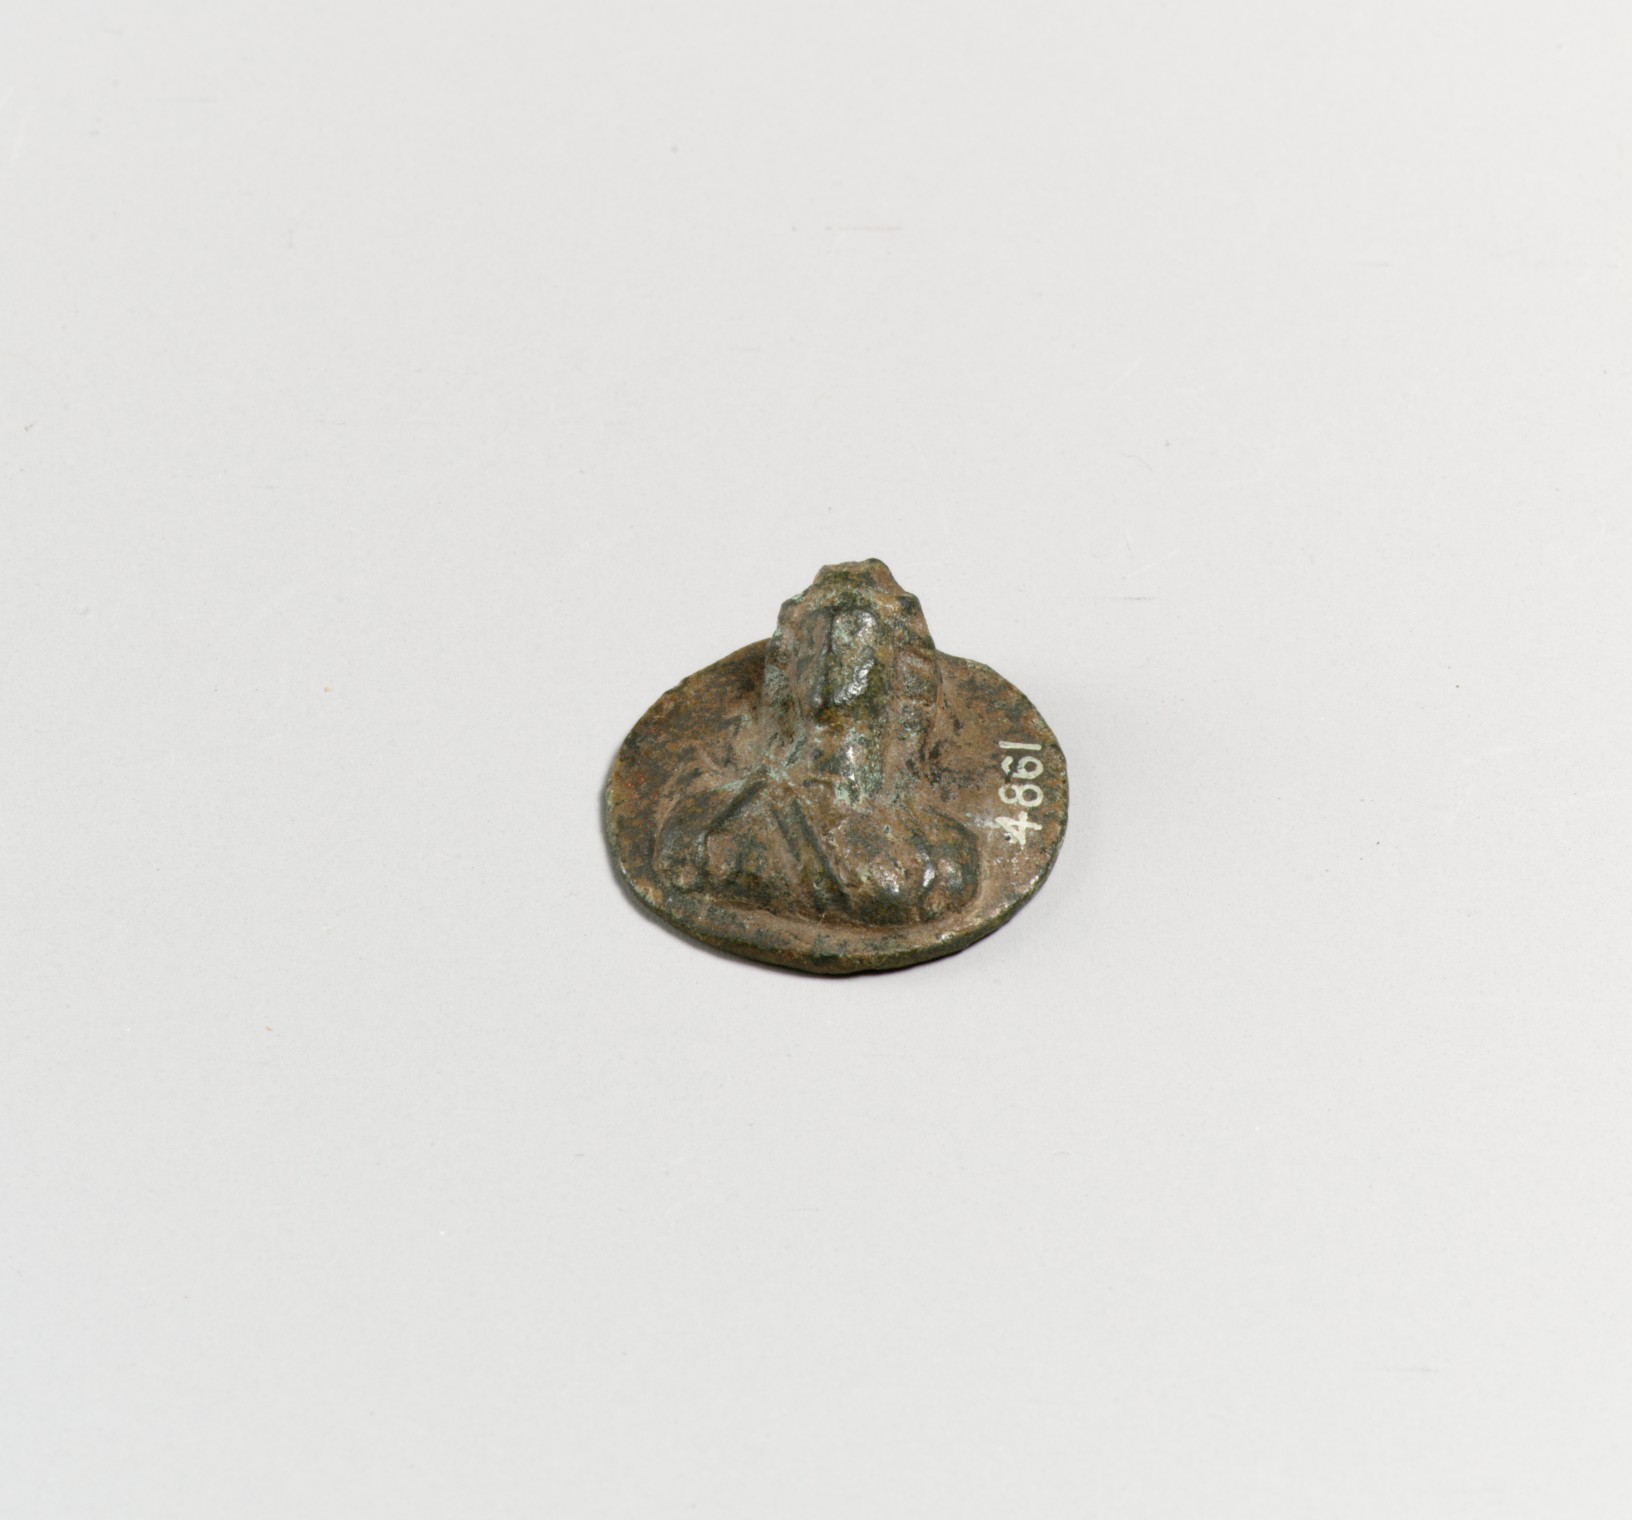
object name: roundel, medallion with head of artemis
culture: roman, cypriot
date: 50-400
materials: bronze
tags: heads,artemis